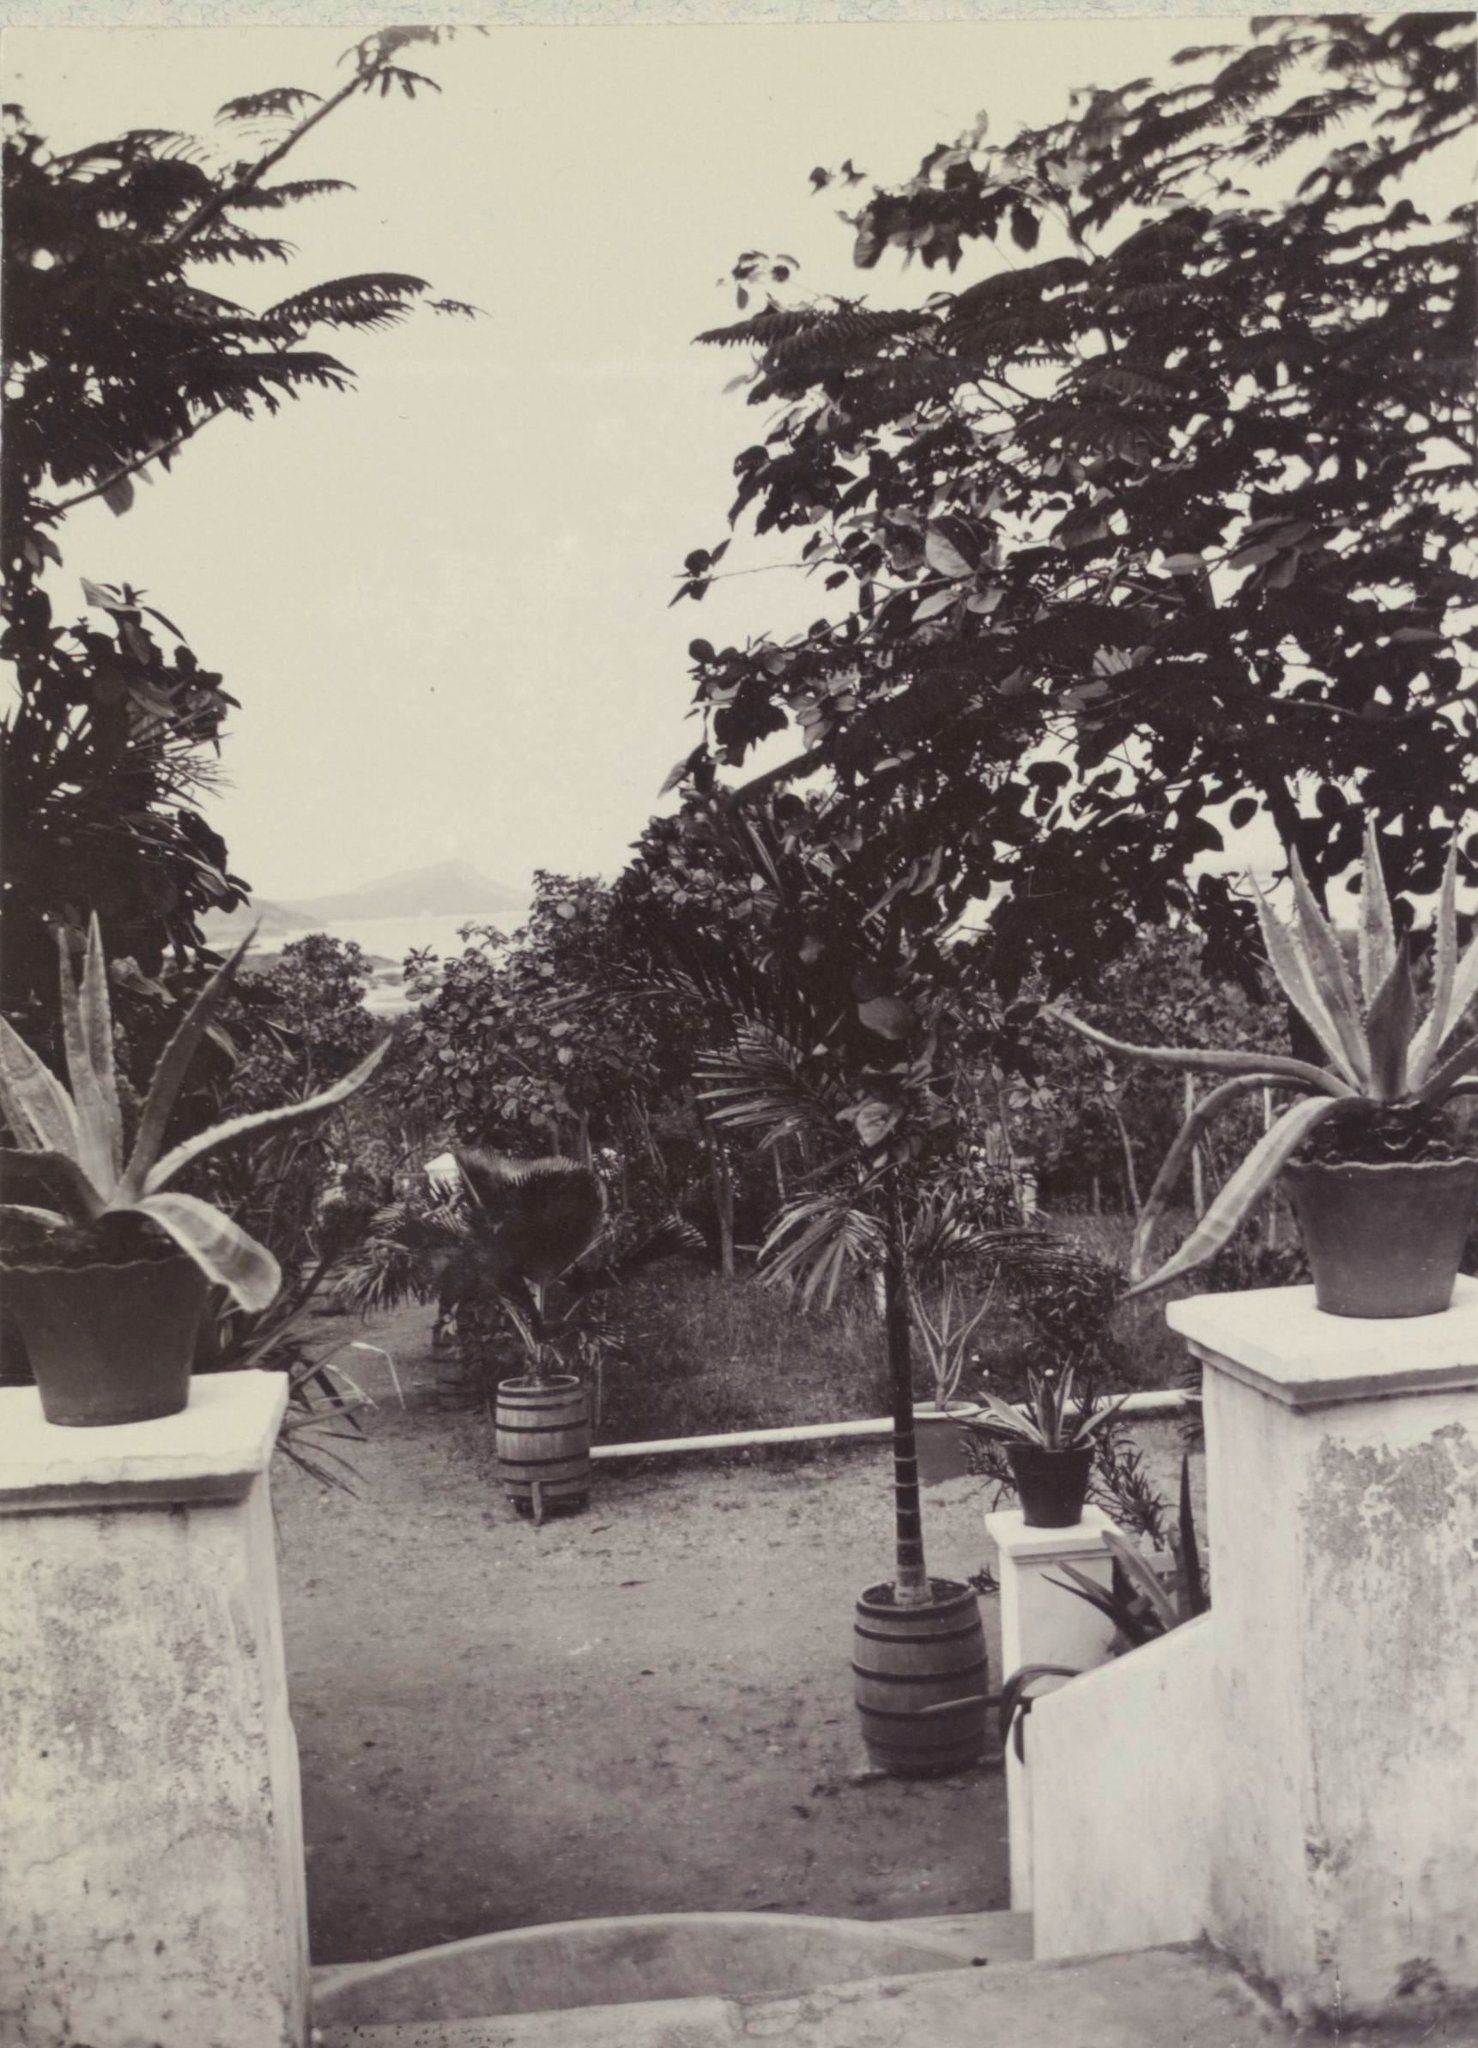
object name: photograph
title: Tuin op in Willemstad op Curaçao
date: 1902-1911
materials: photographic support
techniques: photography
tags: garden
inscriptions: inscription: ‘Tuin van ... In 't verschiet de "Utrecht". Curaçao Febr. 1911’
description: Gezicht vanuit de tuin van het echtpaar Land op Klein Davelaar naar het Schottegat en de baai van Willemstad op Curaçao, februari 1911. Onderdeel van het fotoalbum van de familie Boom-Gonggrijp in Suriname en Curaçao.